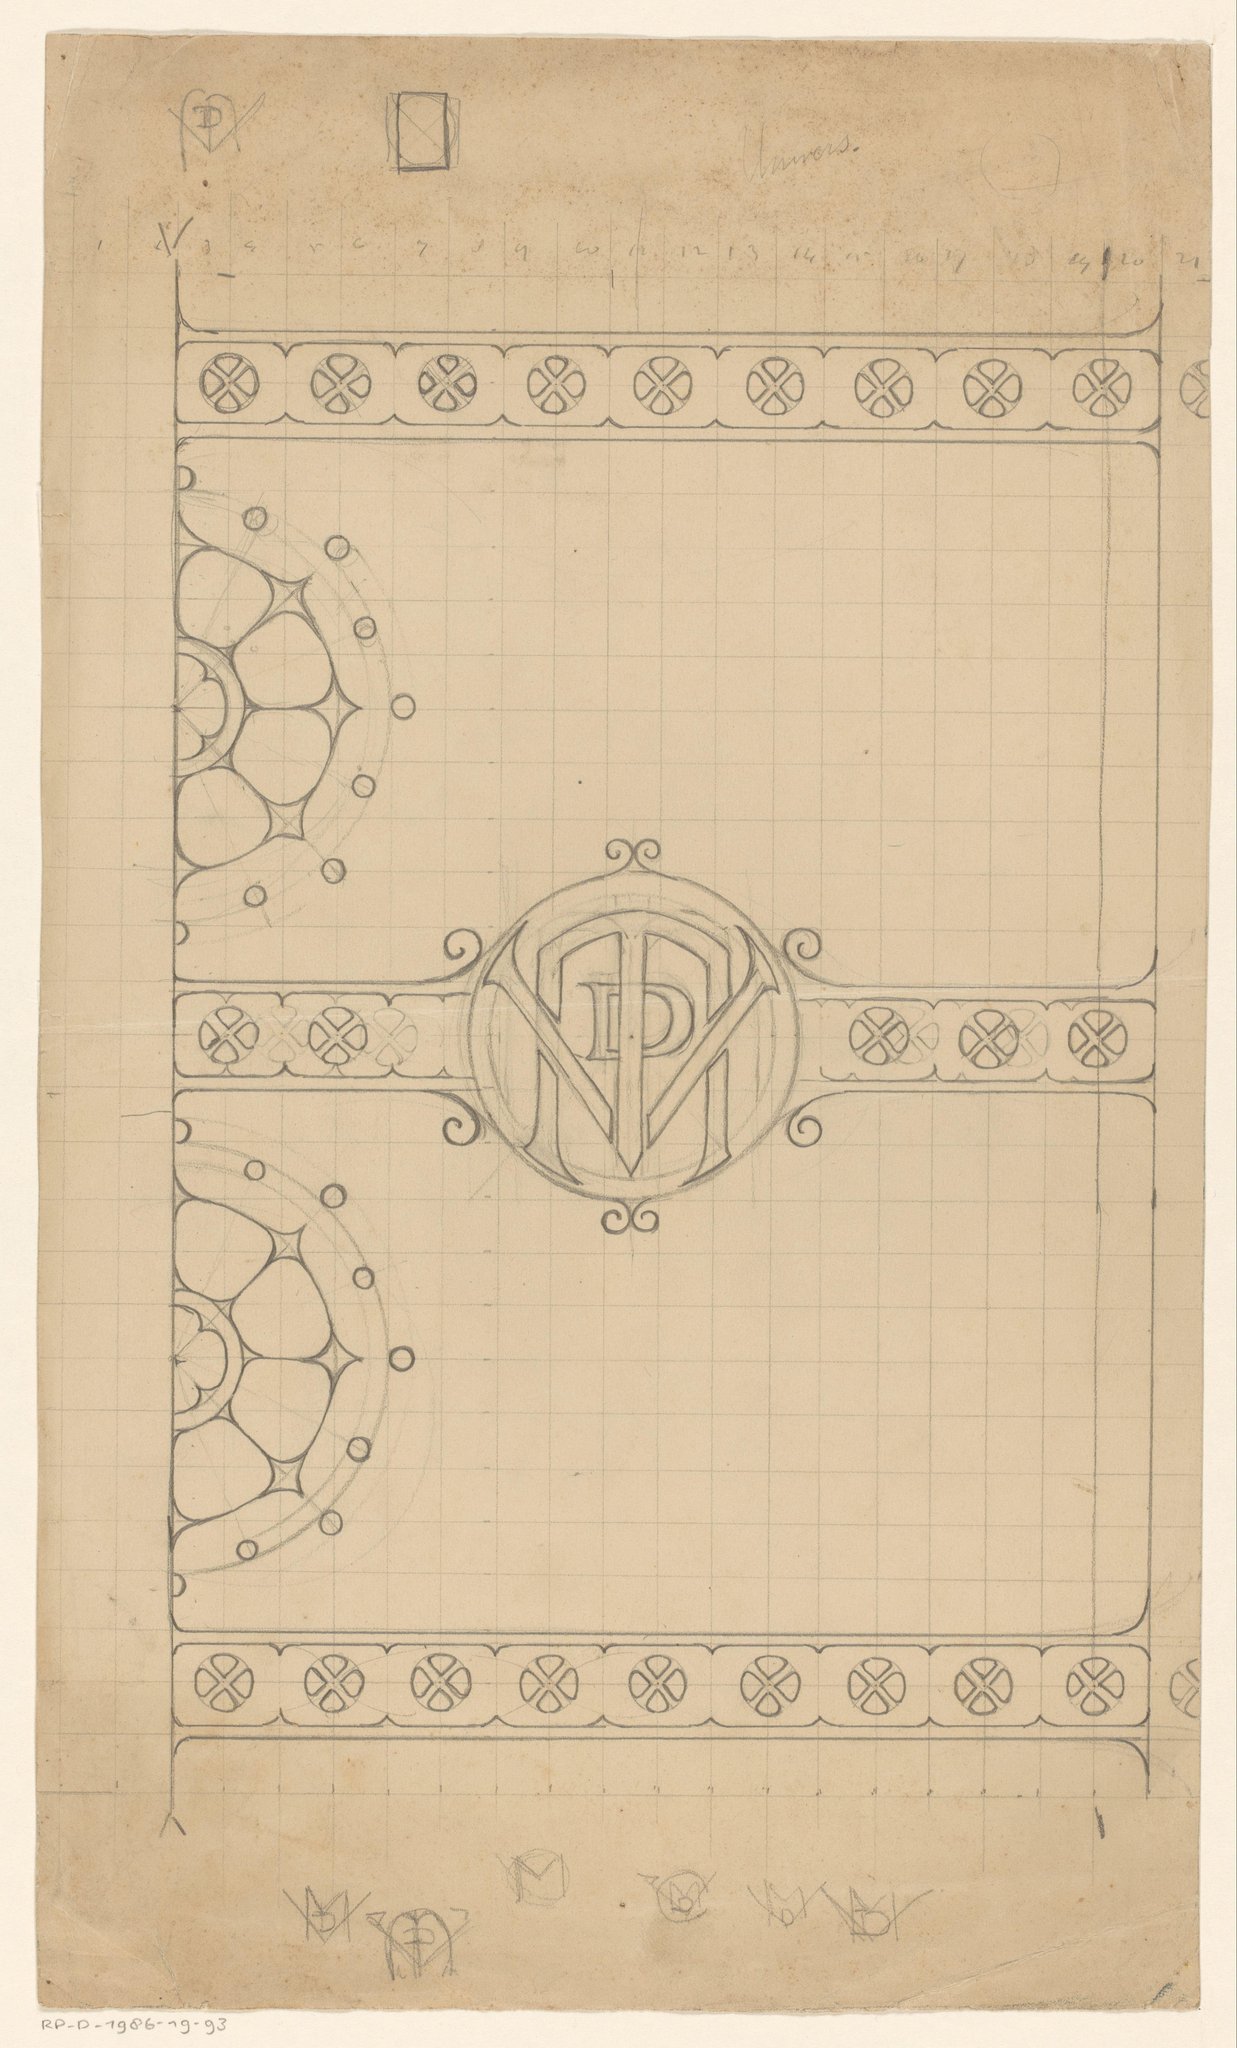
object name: drawing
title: Bandontwerp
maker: reinier willem petrus de vries (1874-1953)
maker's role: draughtsman, print maker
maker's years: 1874-1953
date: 1884-1952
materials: ink, paper, pencil, watercolor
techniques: brush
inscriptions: collector's mark: ‘R:MVS.’